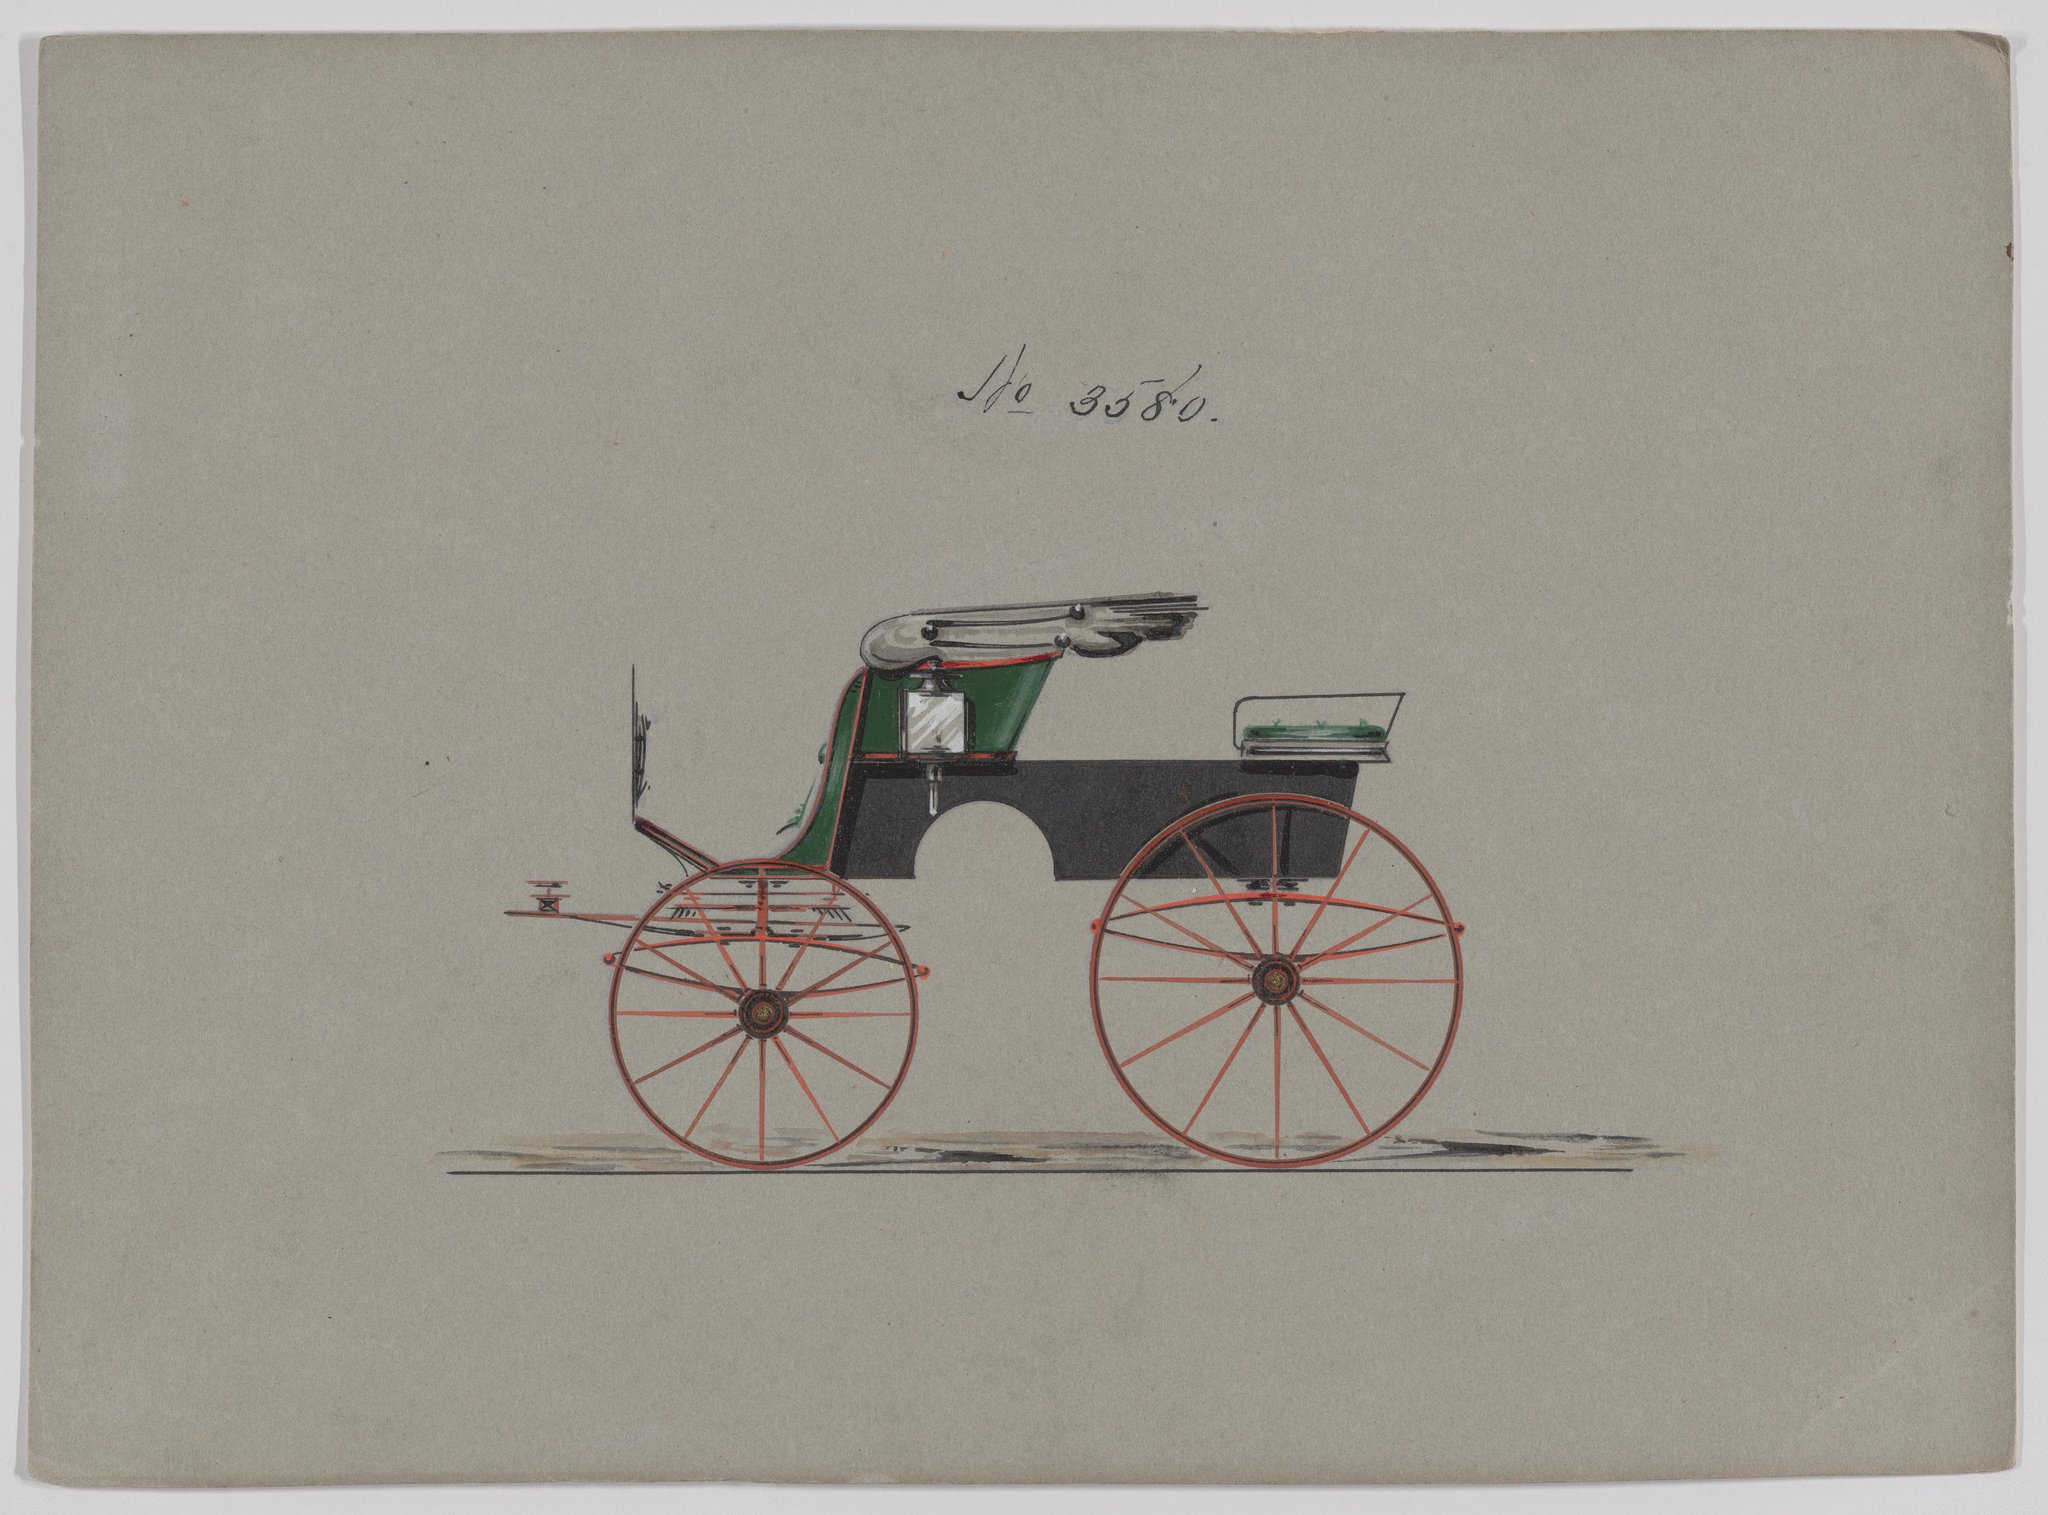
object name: drawing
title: Design for Stanhope Phaeton, no. 3580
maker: brewster & co.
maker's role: manufacturer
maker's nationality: american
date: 1880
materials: gouache, gum arabic, ink, watercolor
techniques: pen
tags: carriages